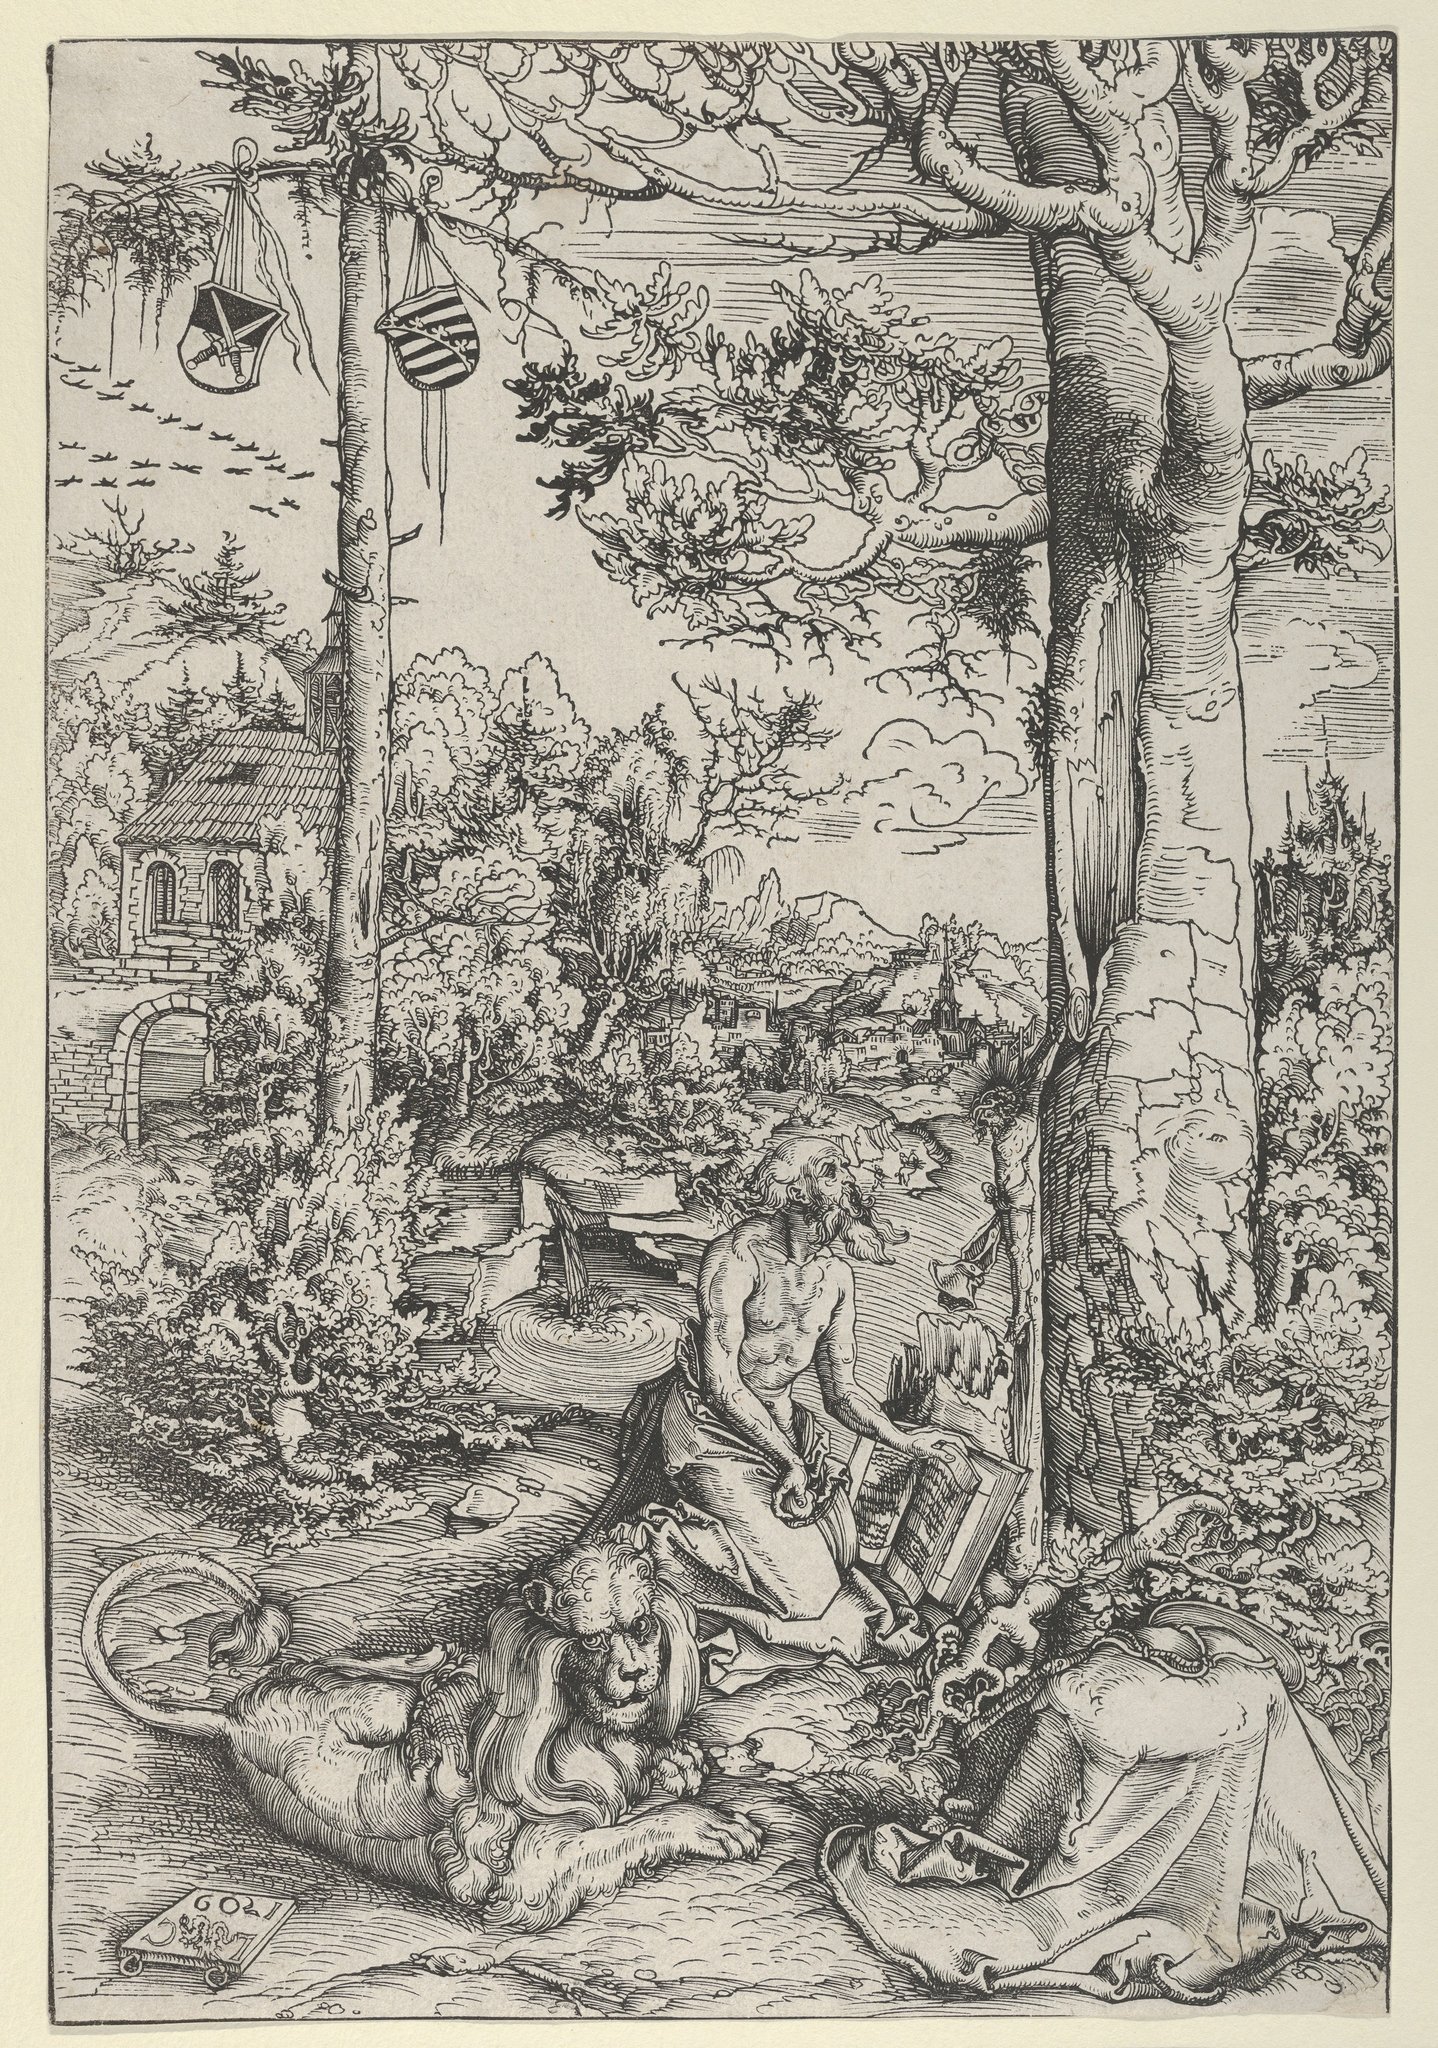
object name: print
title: St. Jerome in the Wilderness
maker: lucas cranach the elder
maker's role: artist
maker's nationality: german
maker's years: 1472-1553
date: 1509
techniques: woodcut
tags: houses,lions,trees,saint jerome